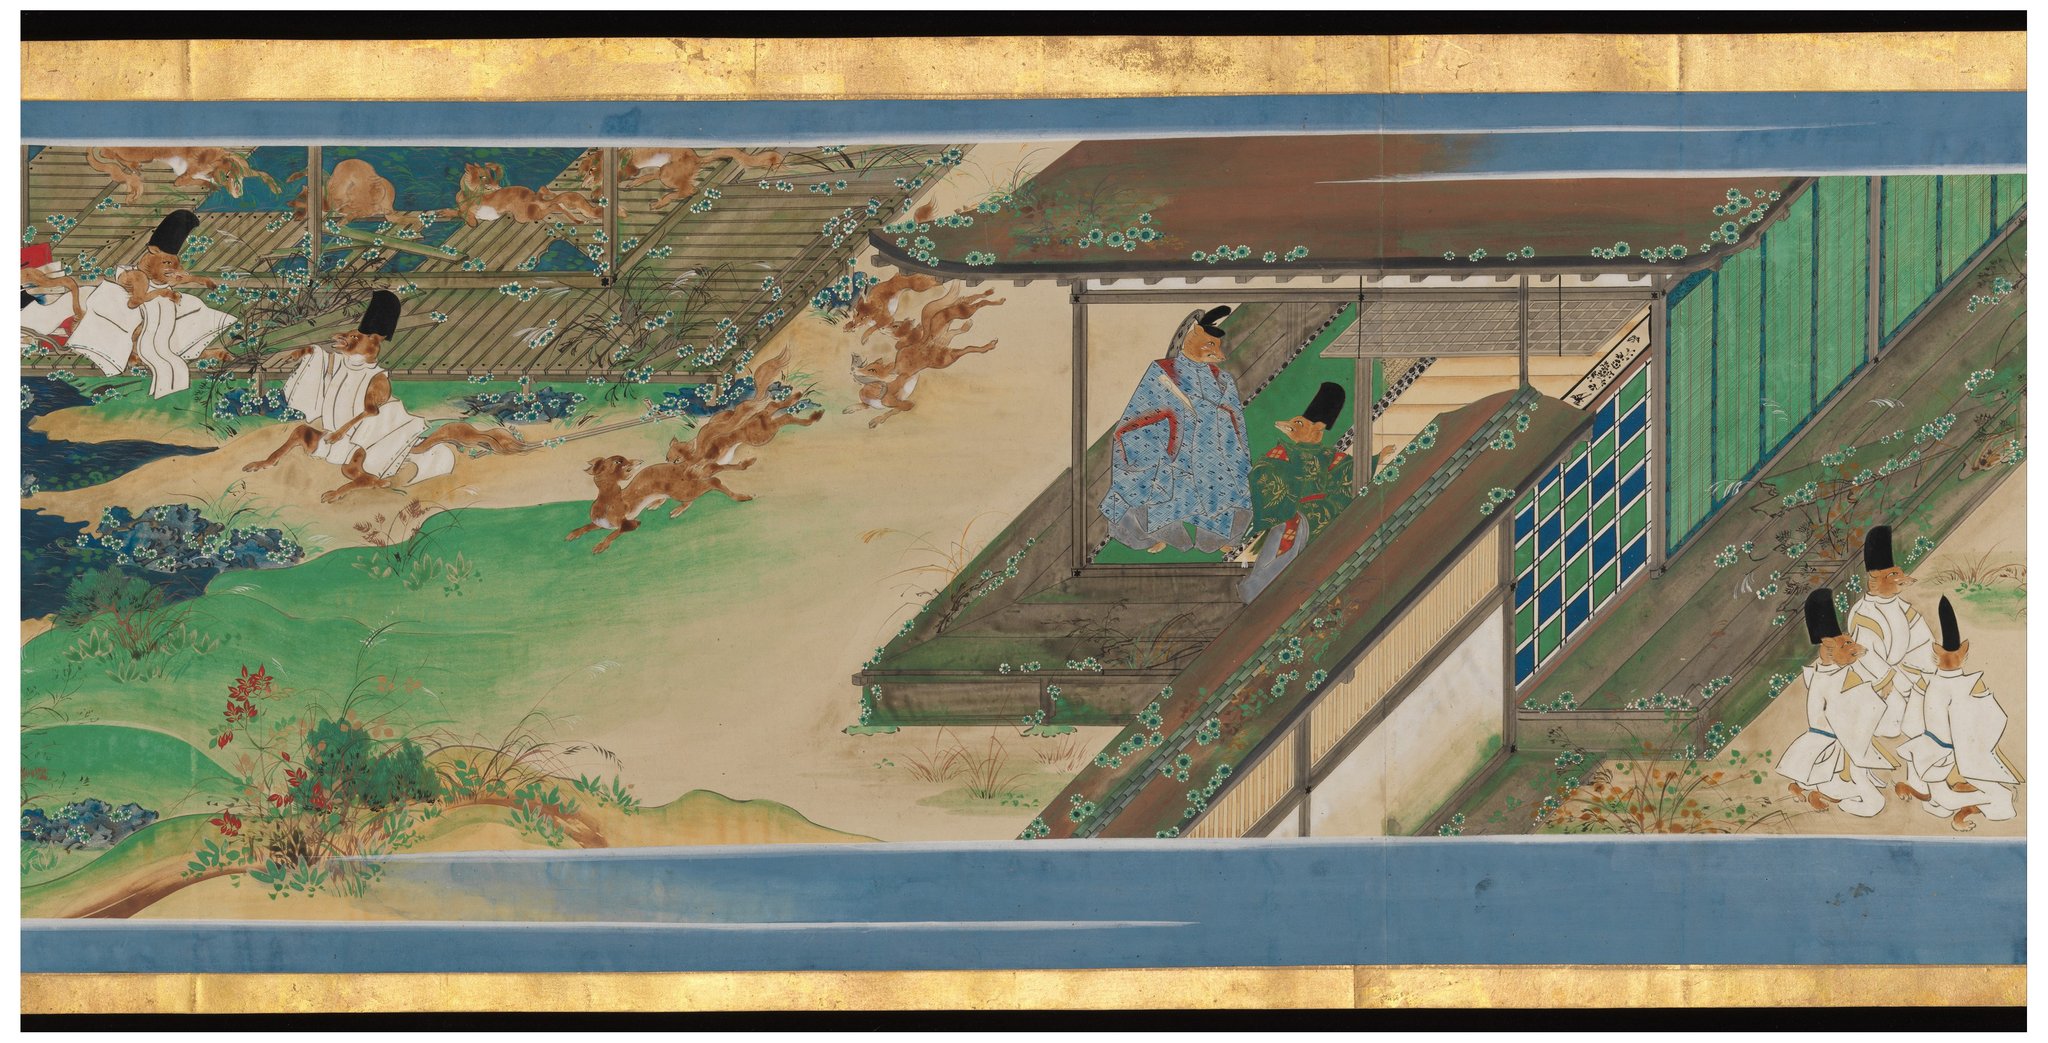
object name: handscroll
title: Tale of a Strange Marriage (Konkai Zoshi)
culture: japanese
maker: ukita ikkei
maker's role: artist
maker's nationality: japanese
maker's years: 1795-1859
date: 1858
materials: ink, paper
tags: foxes